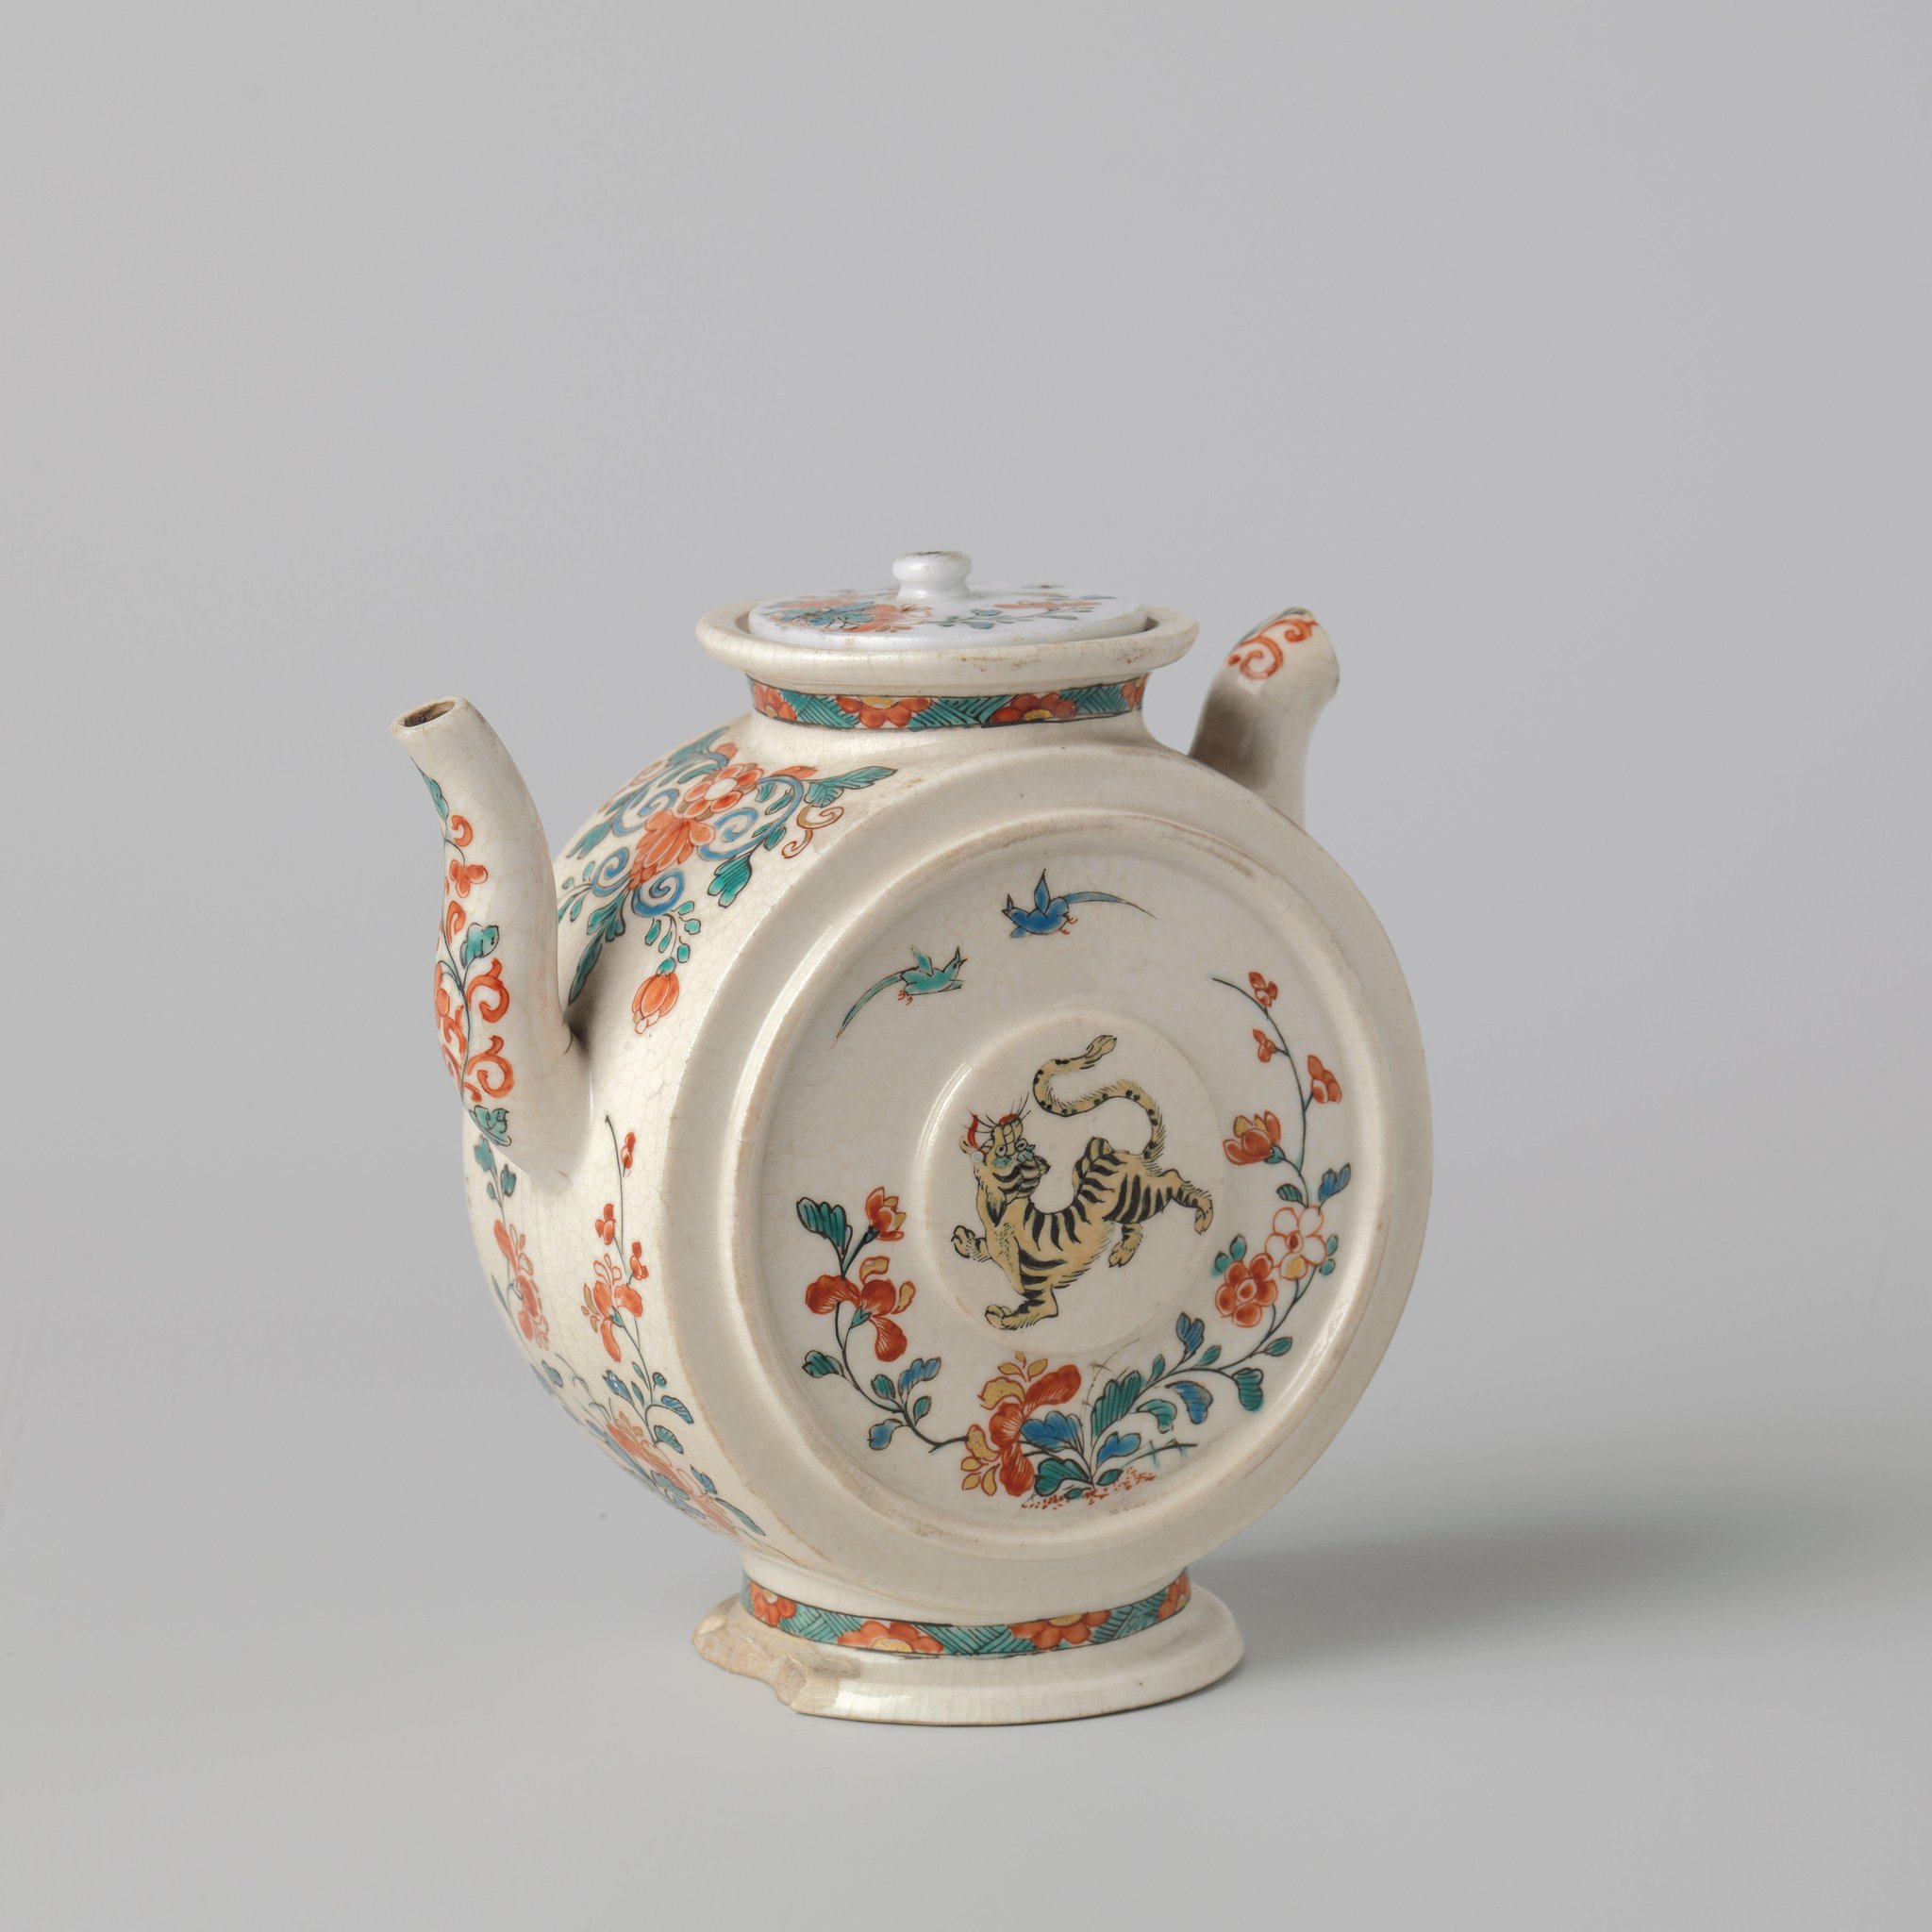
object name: teapot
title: Teapot with a tiger, birds and floral scrolls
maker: Anonymous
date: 1700-1799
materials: glaze, gold, paint, porcelain, soft paste porcelain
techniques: firing, forming, gilding, turning, vitrification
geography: japan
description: Theepot van soft-paste porselein (pâte tendre) op voet en een S-vormige tuit, beschilderd op het glazuur in blauw, rood, groen, geel, zwart en goud. De buik is in de vorm van een op de zijkant staande cilinder, met op de platte wand een verhoogd medaillon en een verhoogde cirkel. Op de wand een tijger, twee vogels en een bloeiende plant. De ronde wand, de tuit en het oor met bloemranken. Op de nek en de voet een band met arceerwerk onderbroken door halve bloemen. Het oor is grotendeels afgebroken. Kakiemon-stijl.